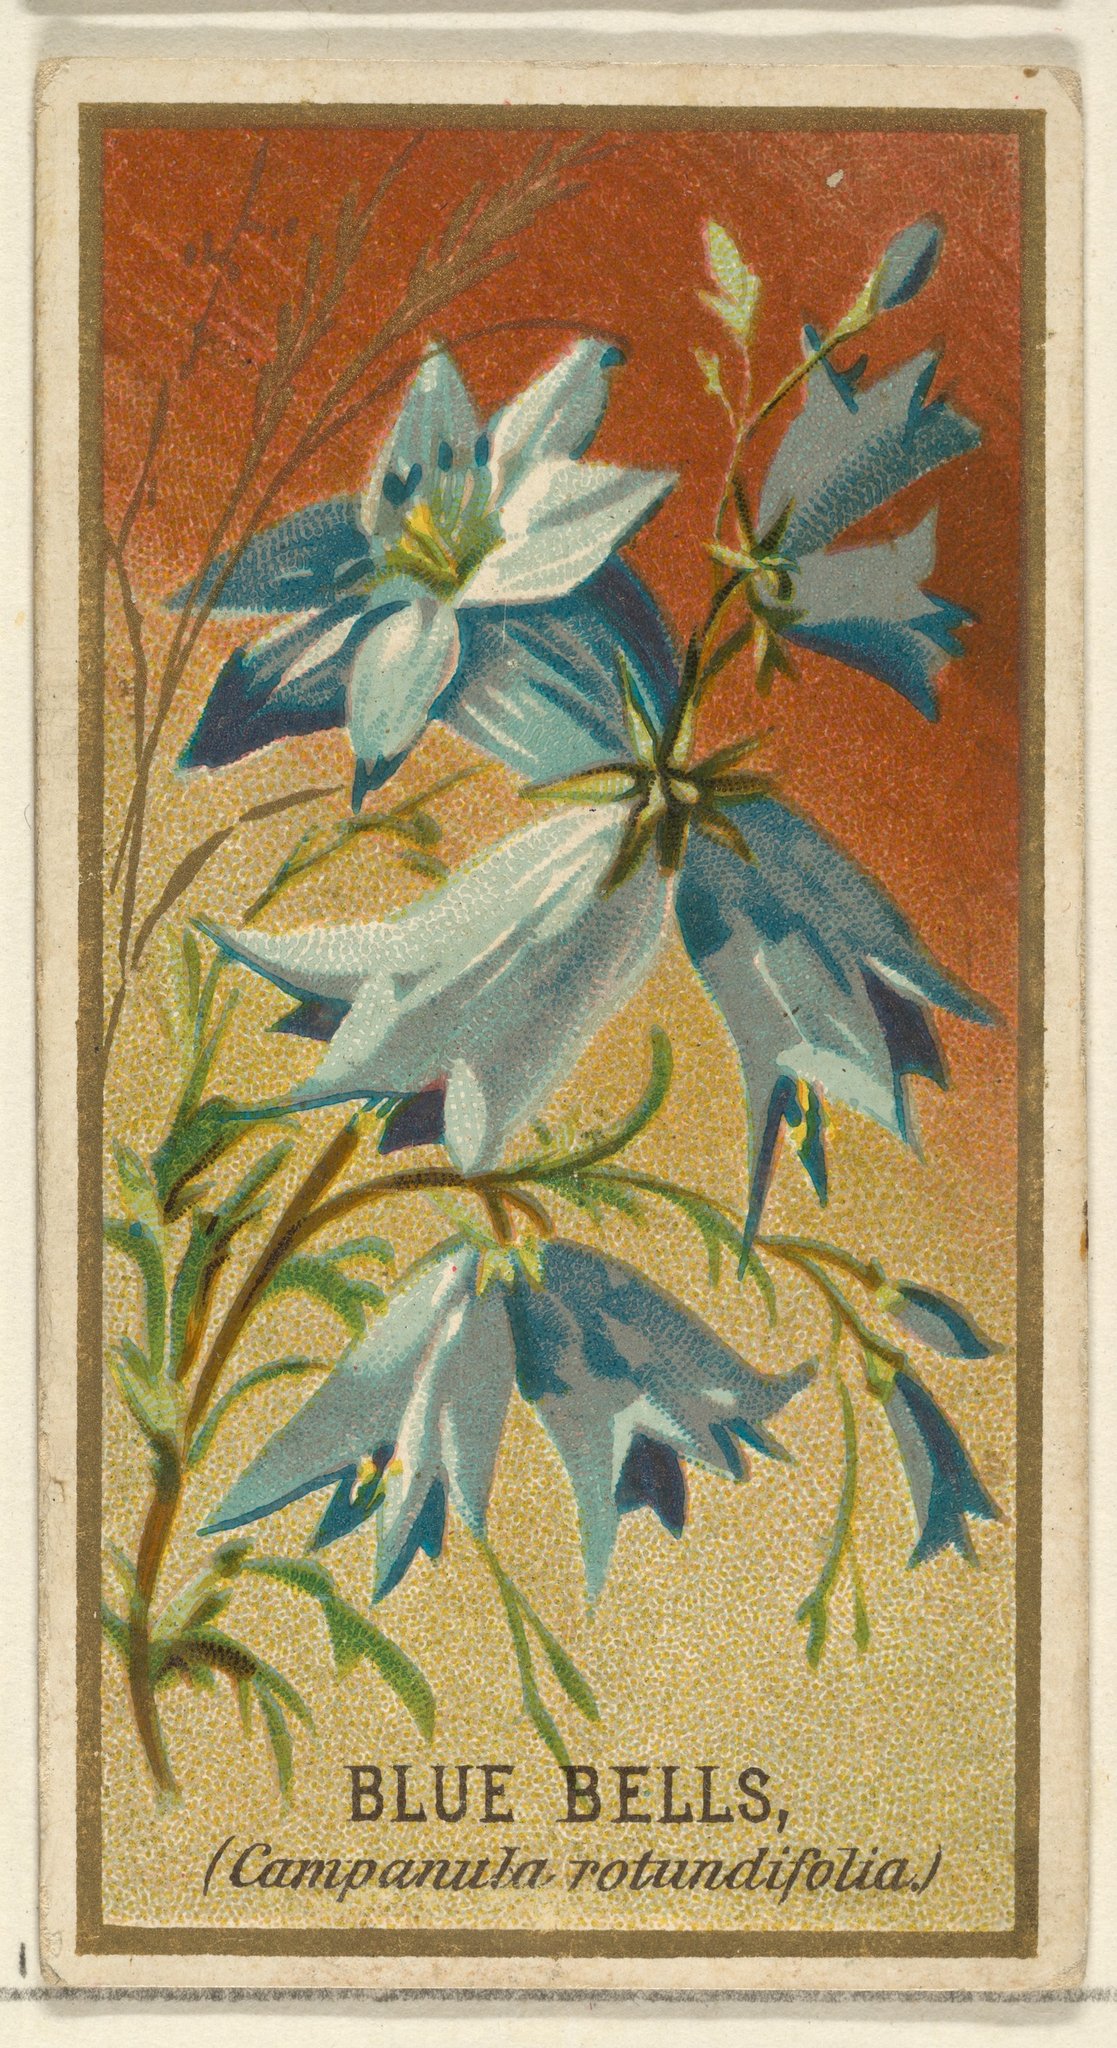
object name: print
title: Bluebells (Campanula rotundifolia), from the Flowers series for Old Judge Cigarettes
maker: goodwin & company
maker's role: publisher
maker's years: 1850-1950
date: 1890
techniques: color lithograph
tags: flowers